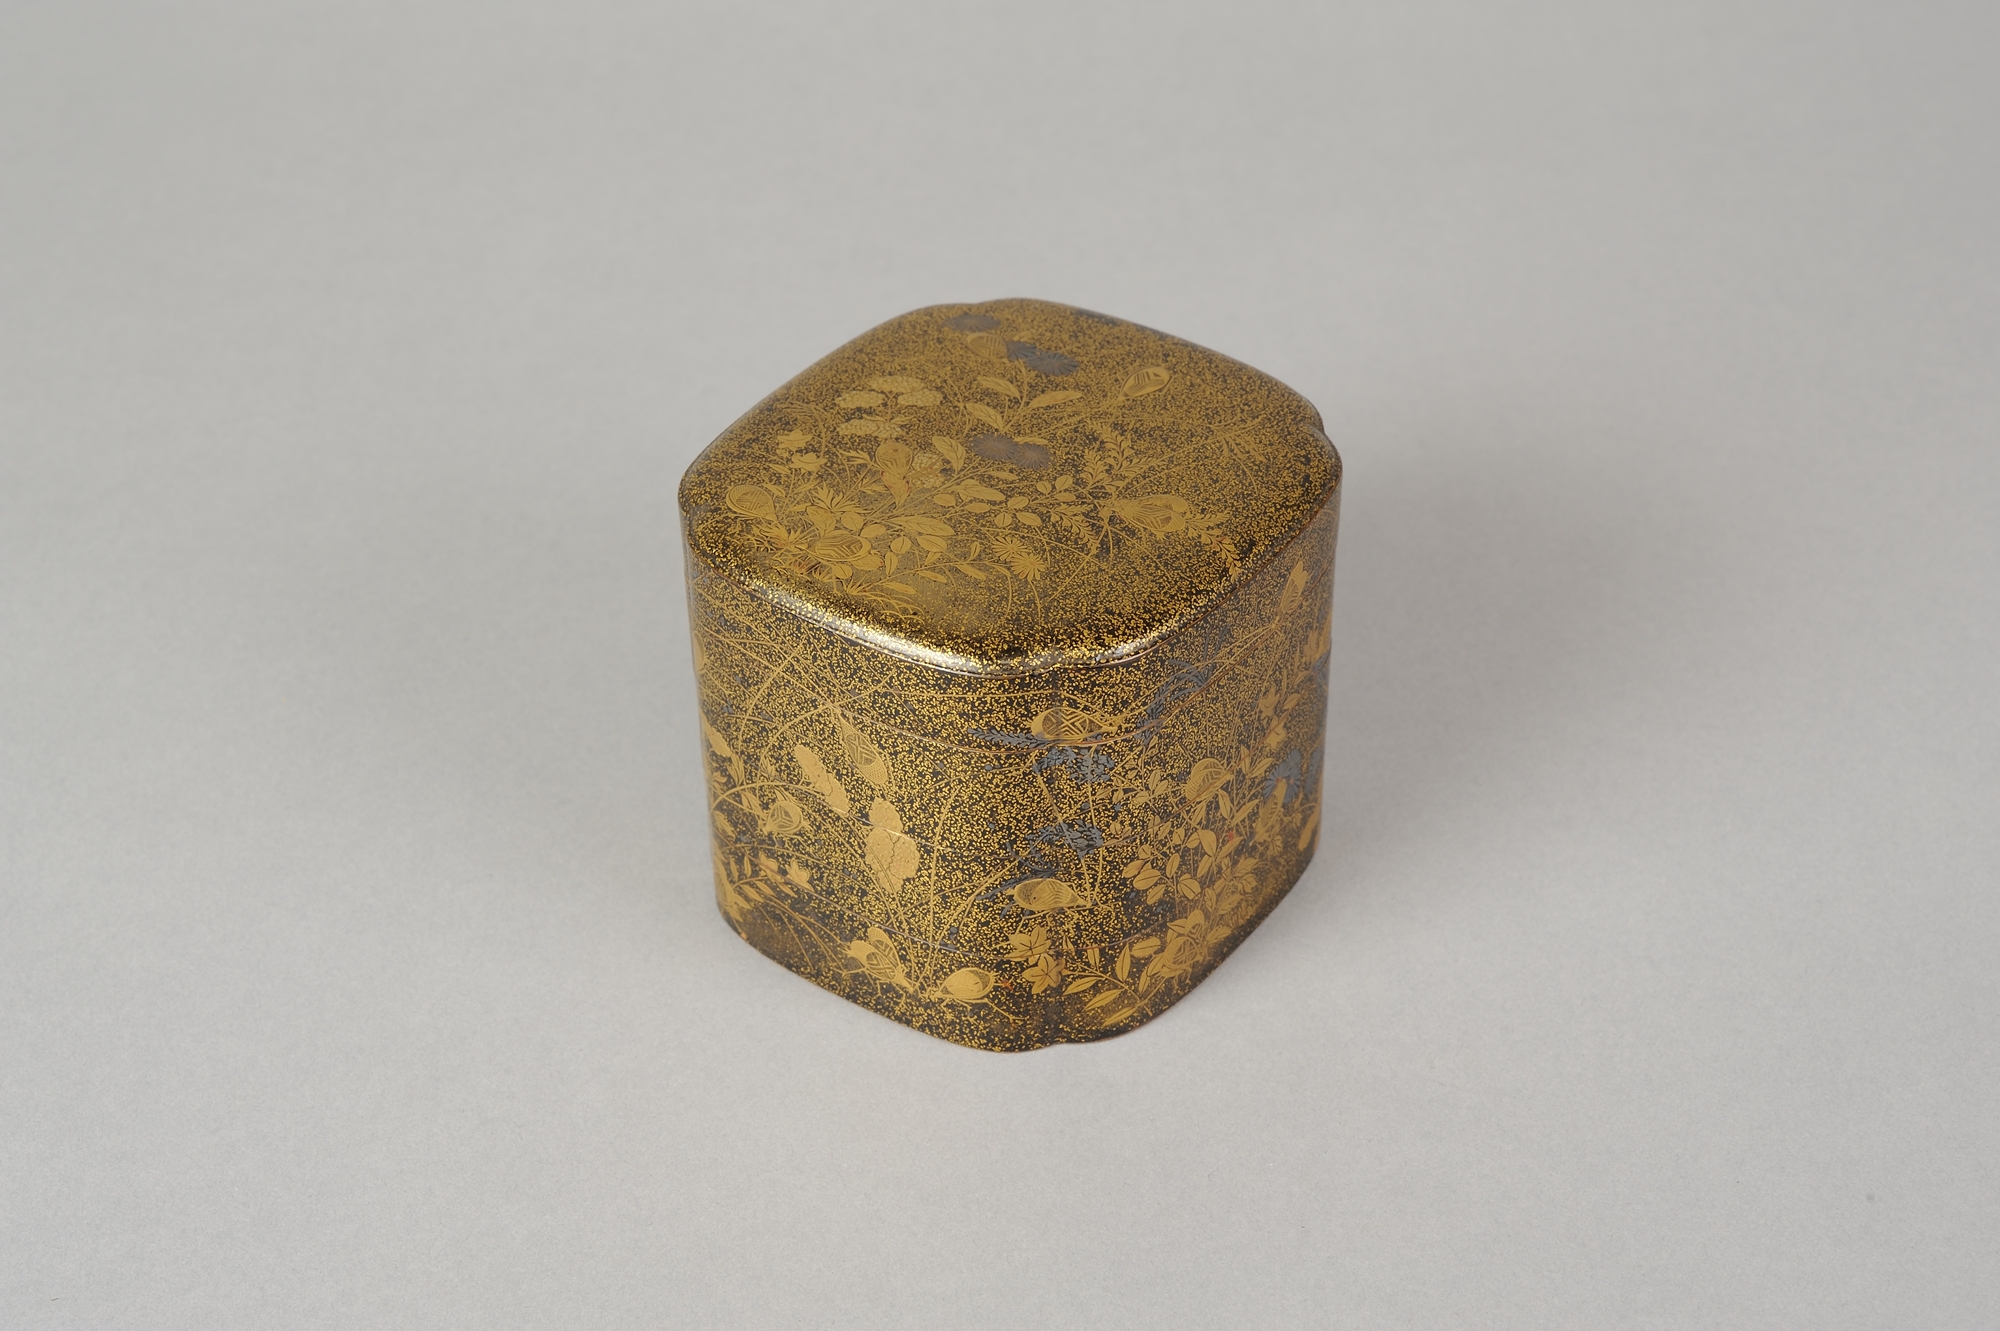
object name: incense box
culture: japanese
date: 1834-1866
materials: lacquer